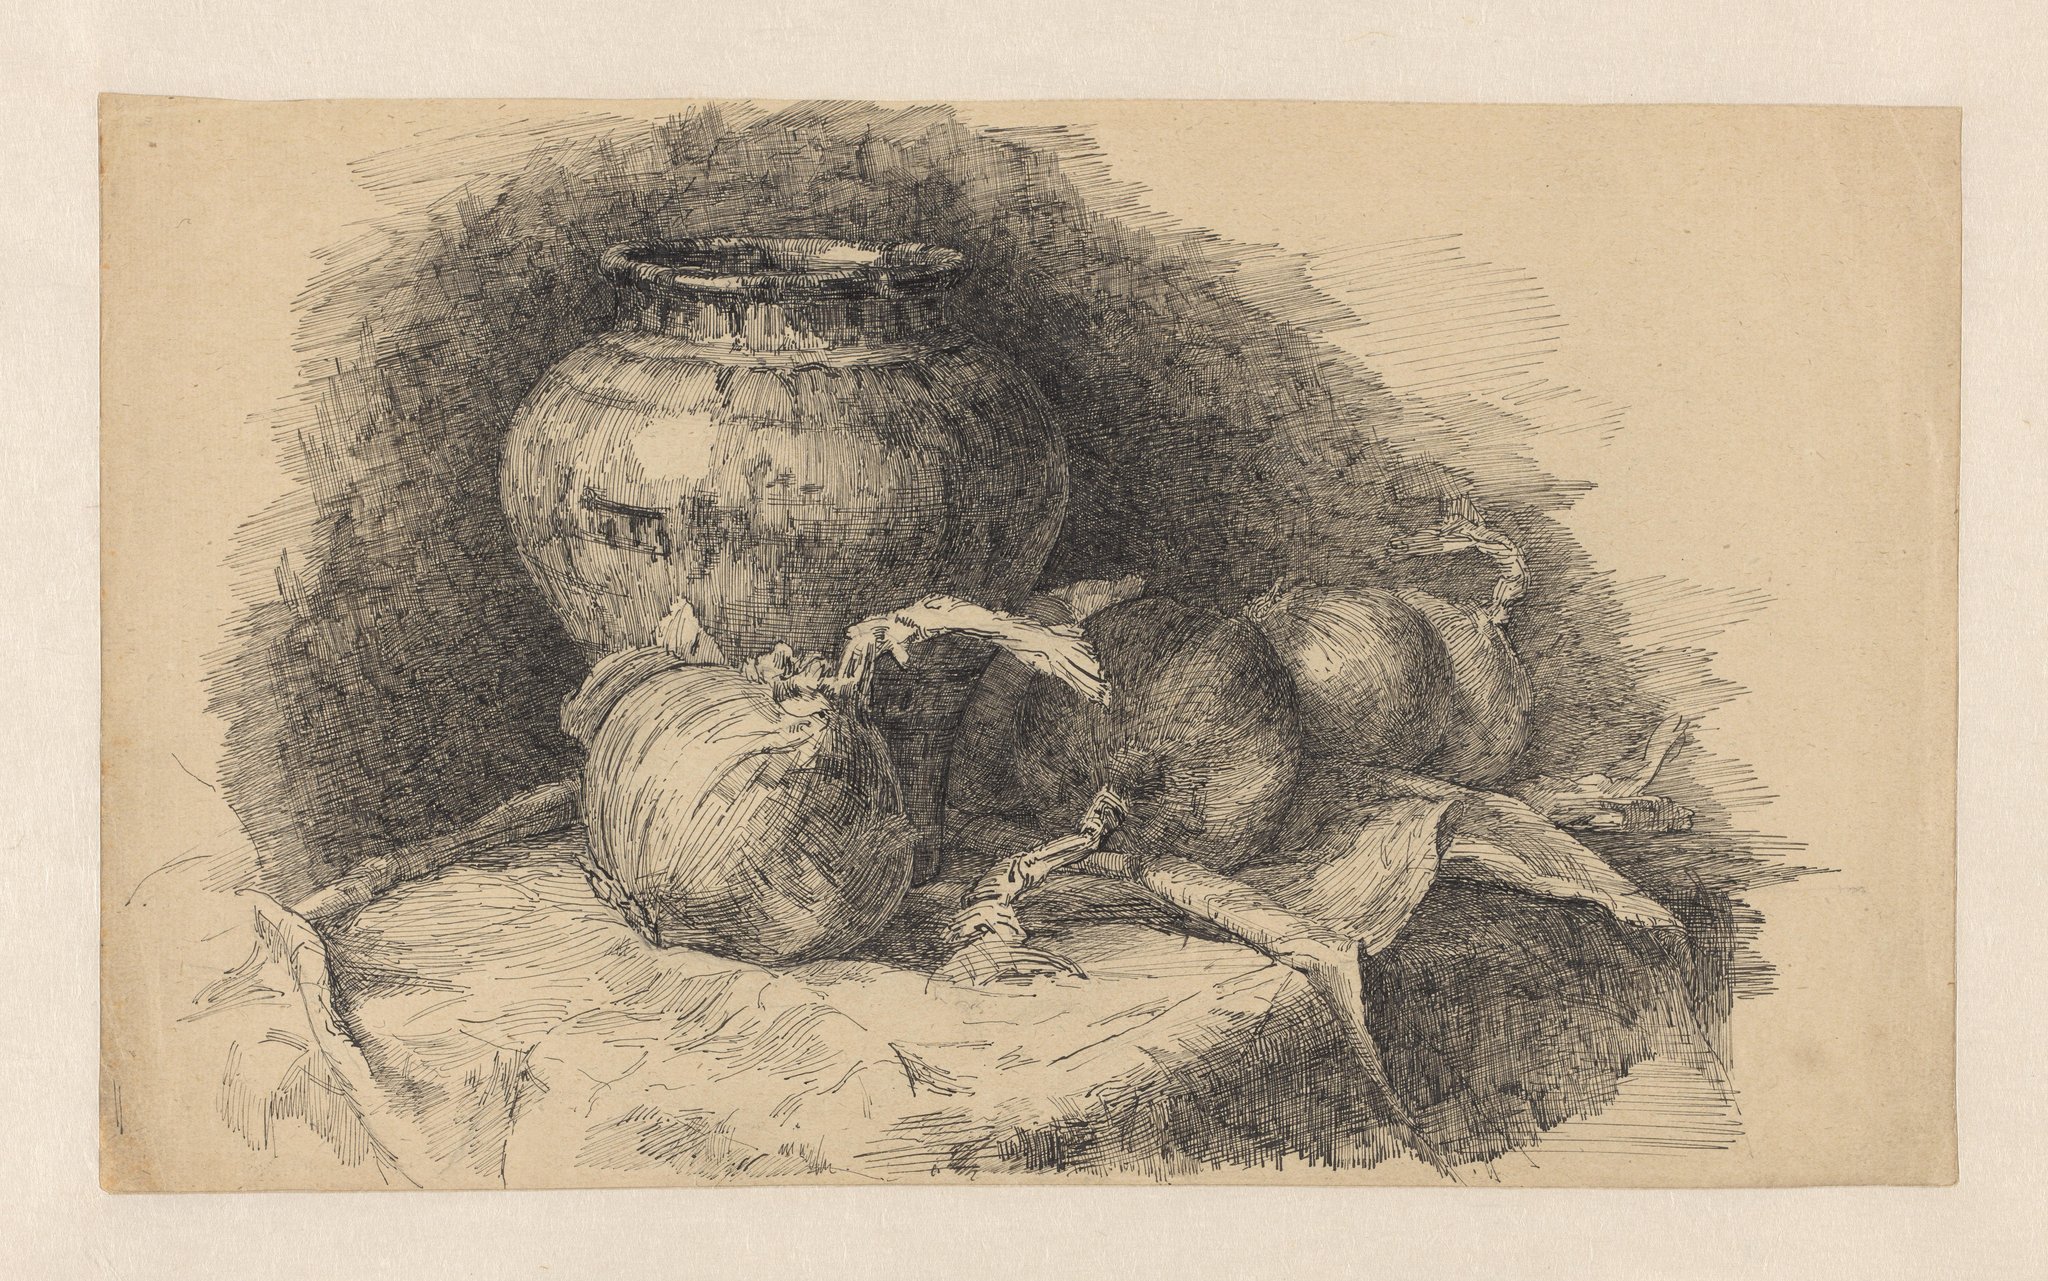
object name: schetsblad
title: Stilleven met pot en uien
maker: johanna behrend-croiset van der kop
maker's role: draughtsman, painter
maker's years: 1861-1943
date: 1880-1900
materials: ink, paper, pencil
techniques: pen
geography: netherlands